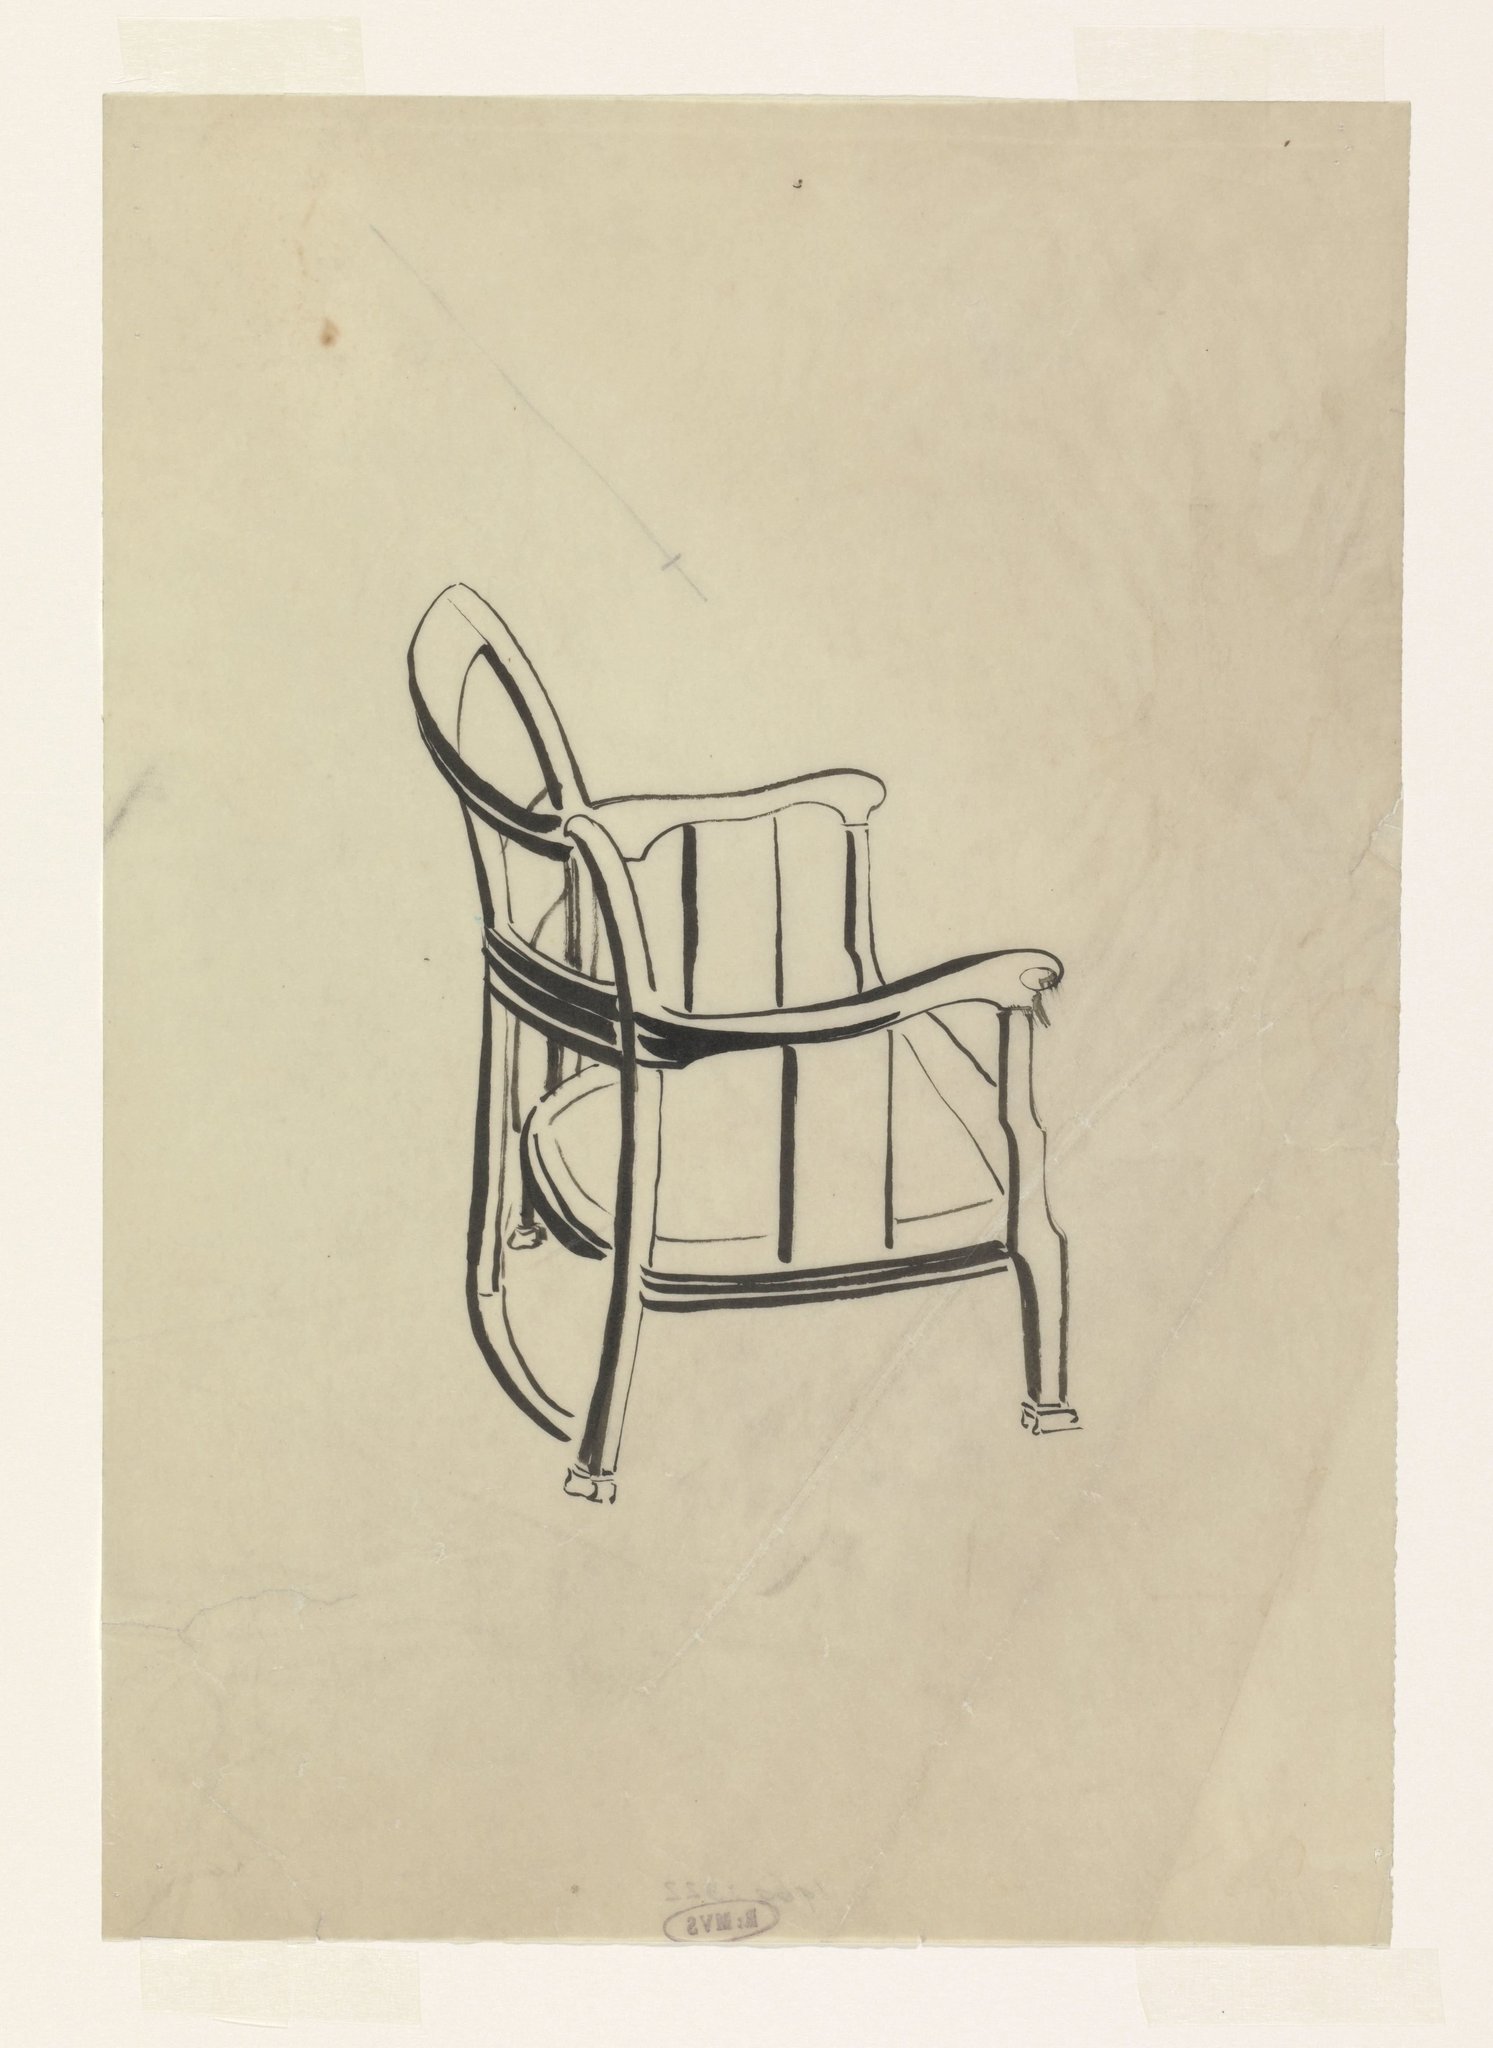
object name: design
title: Ontwerp voor een monumentale bank ter ere van burgemeester van Haarlem Cornelis Maarschalk van Egmond en Rinnegom; studies van het familiewapen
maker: carel adolph lion cachet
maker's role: draughtsman, print maker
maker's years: 1864-1945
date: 1874-1945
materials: pencil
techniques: brush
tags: mayor, bench, work of monumental art, municipal government, armorial bearing, heraldry, haarlem